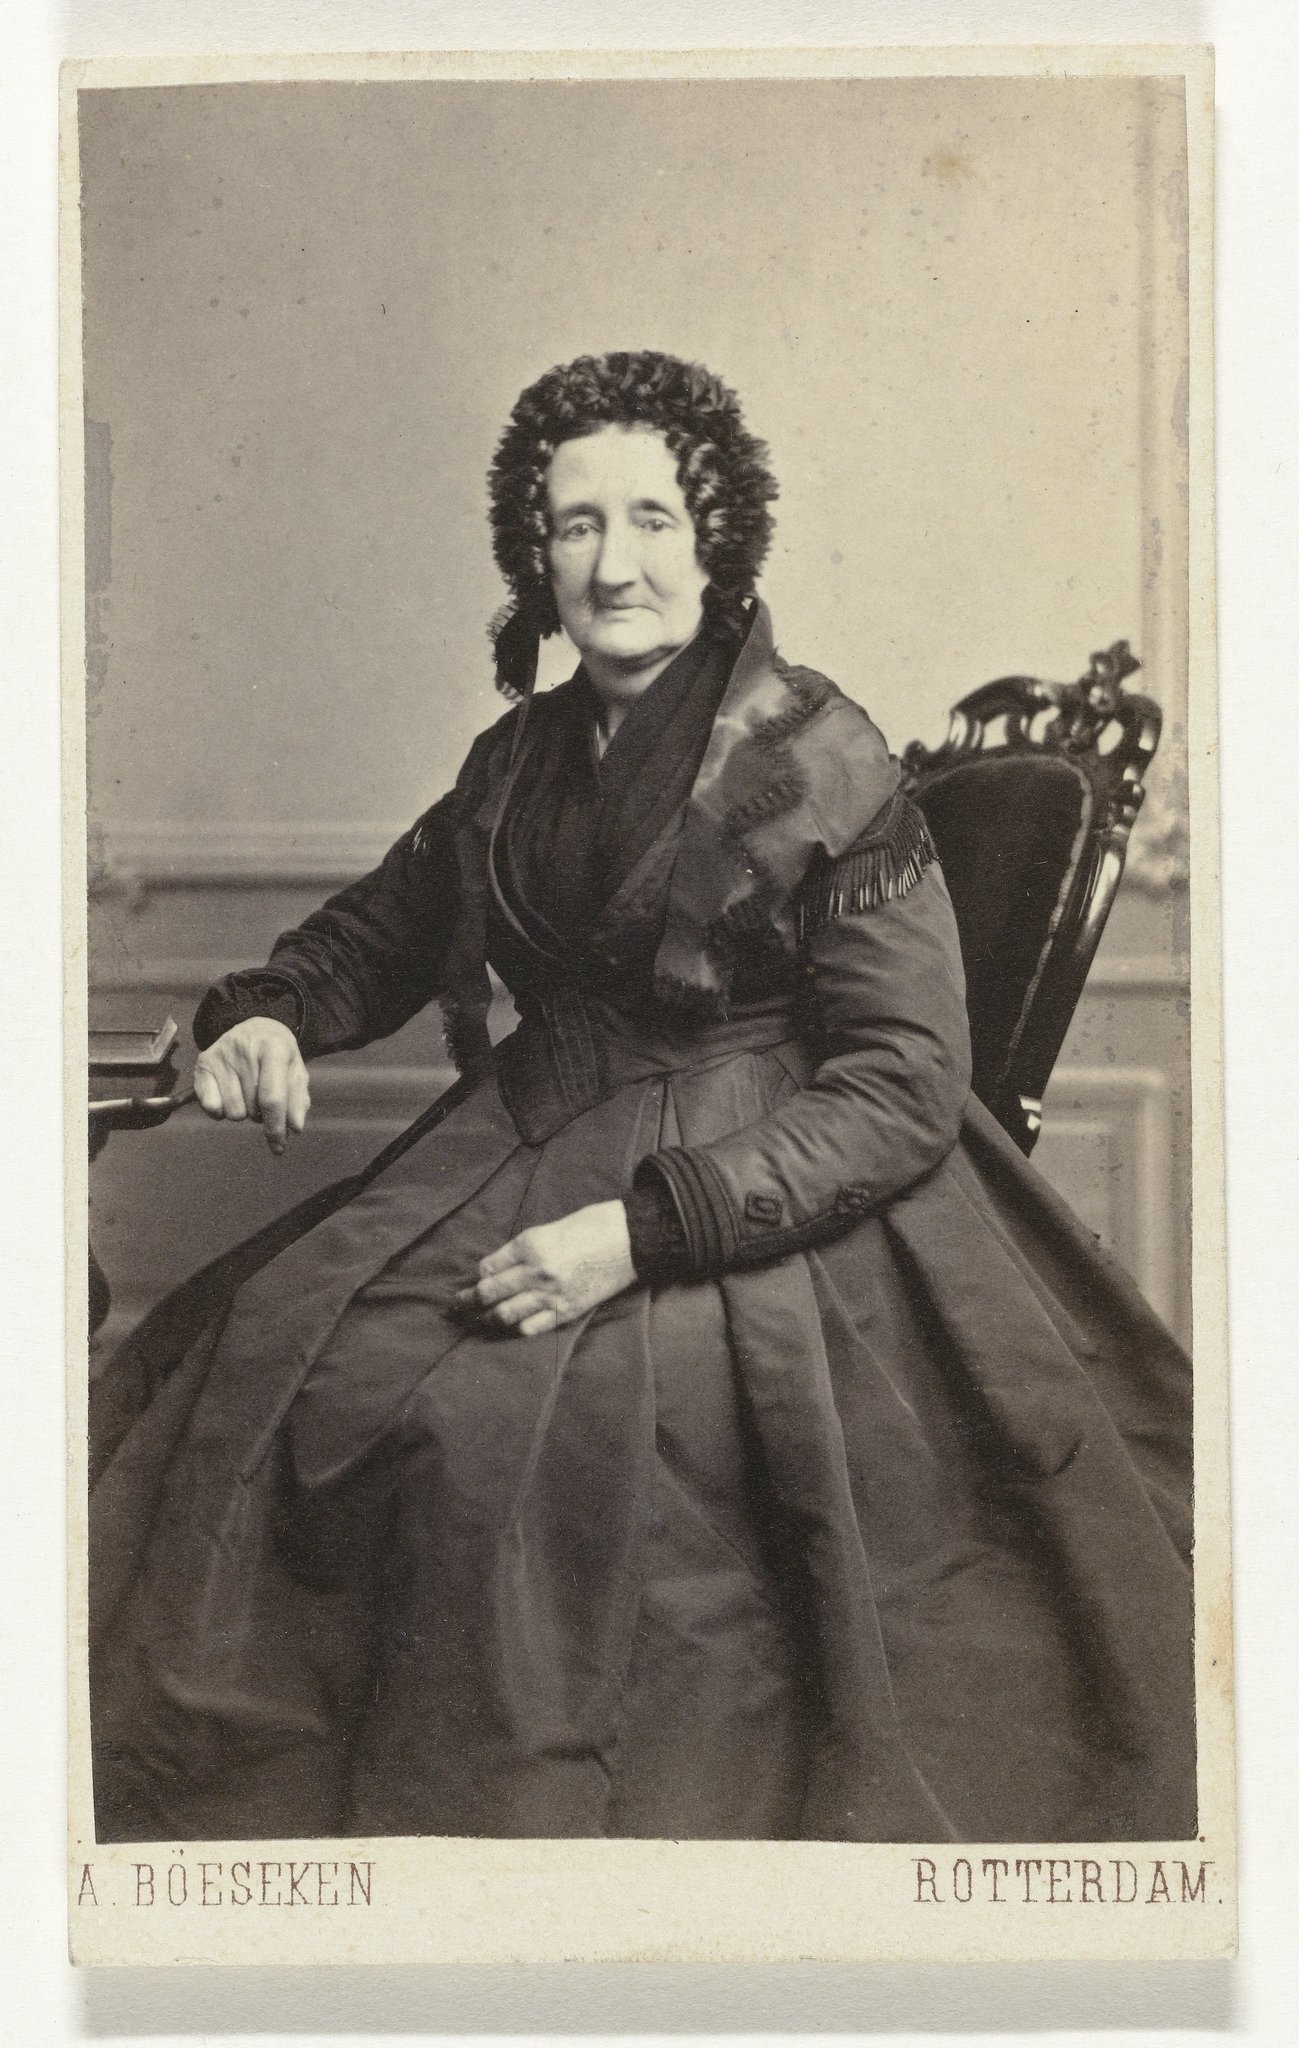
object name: photograph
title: Portret van een oudere vrouw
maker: a. böeseken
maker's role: fotograaf, lithograaf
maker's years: 1834-1919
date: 1870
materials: cardboard, paper, photographic support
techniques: albumen print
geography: rotterdam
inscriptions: address: ‘Photographisch Atelier/A. Böeseken/Hoogstraat over de Vlasmarkt/Rotterdam’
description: Oudere vrouw in een donkere japon, zittend aan een tafel.